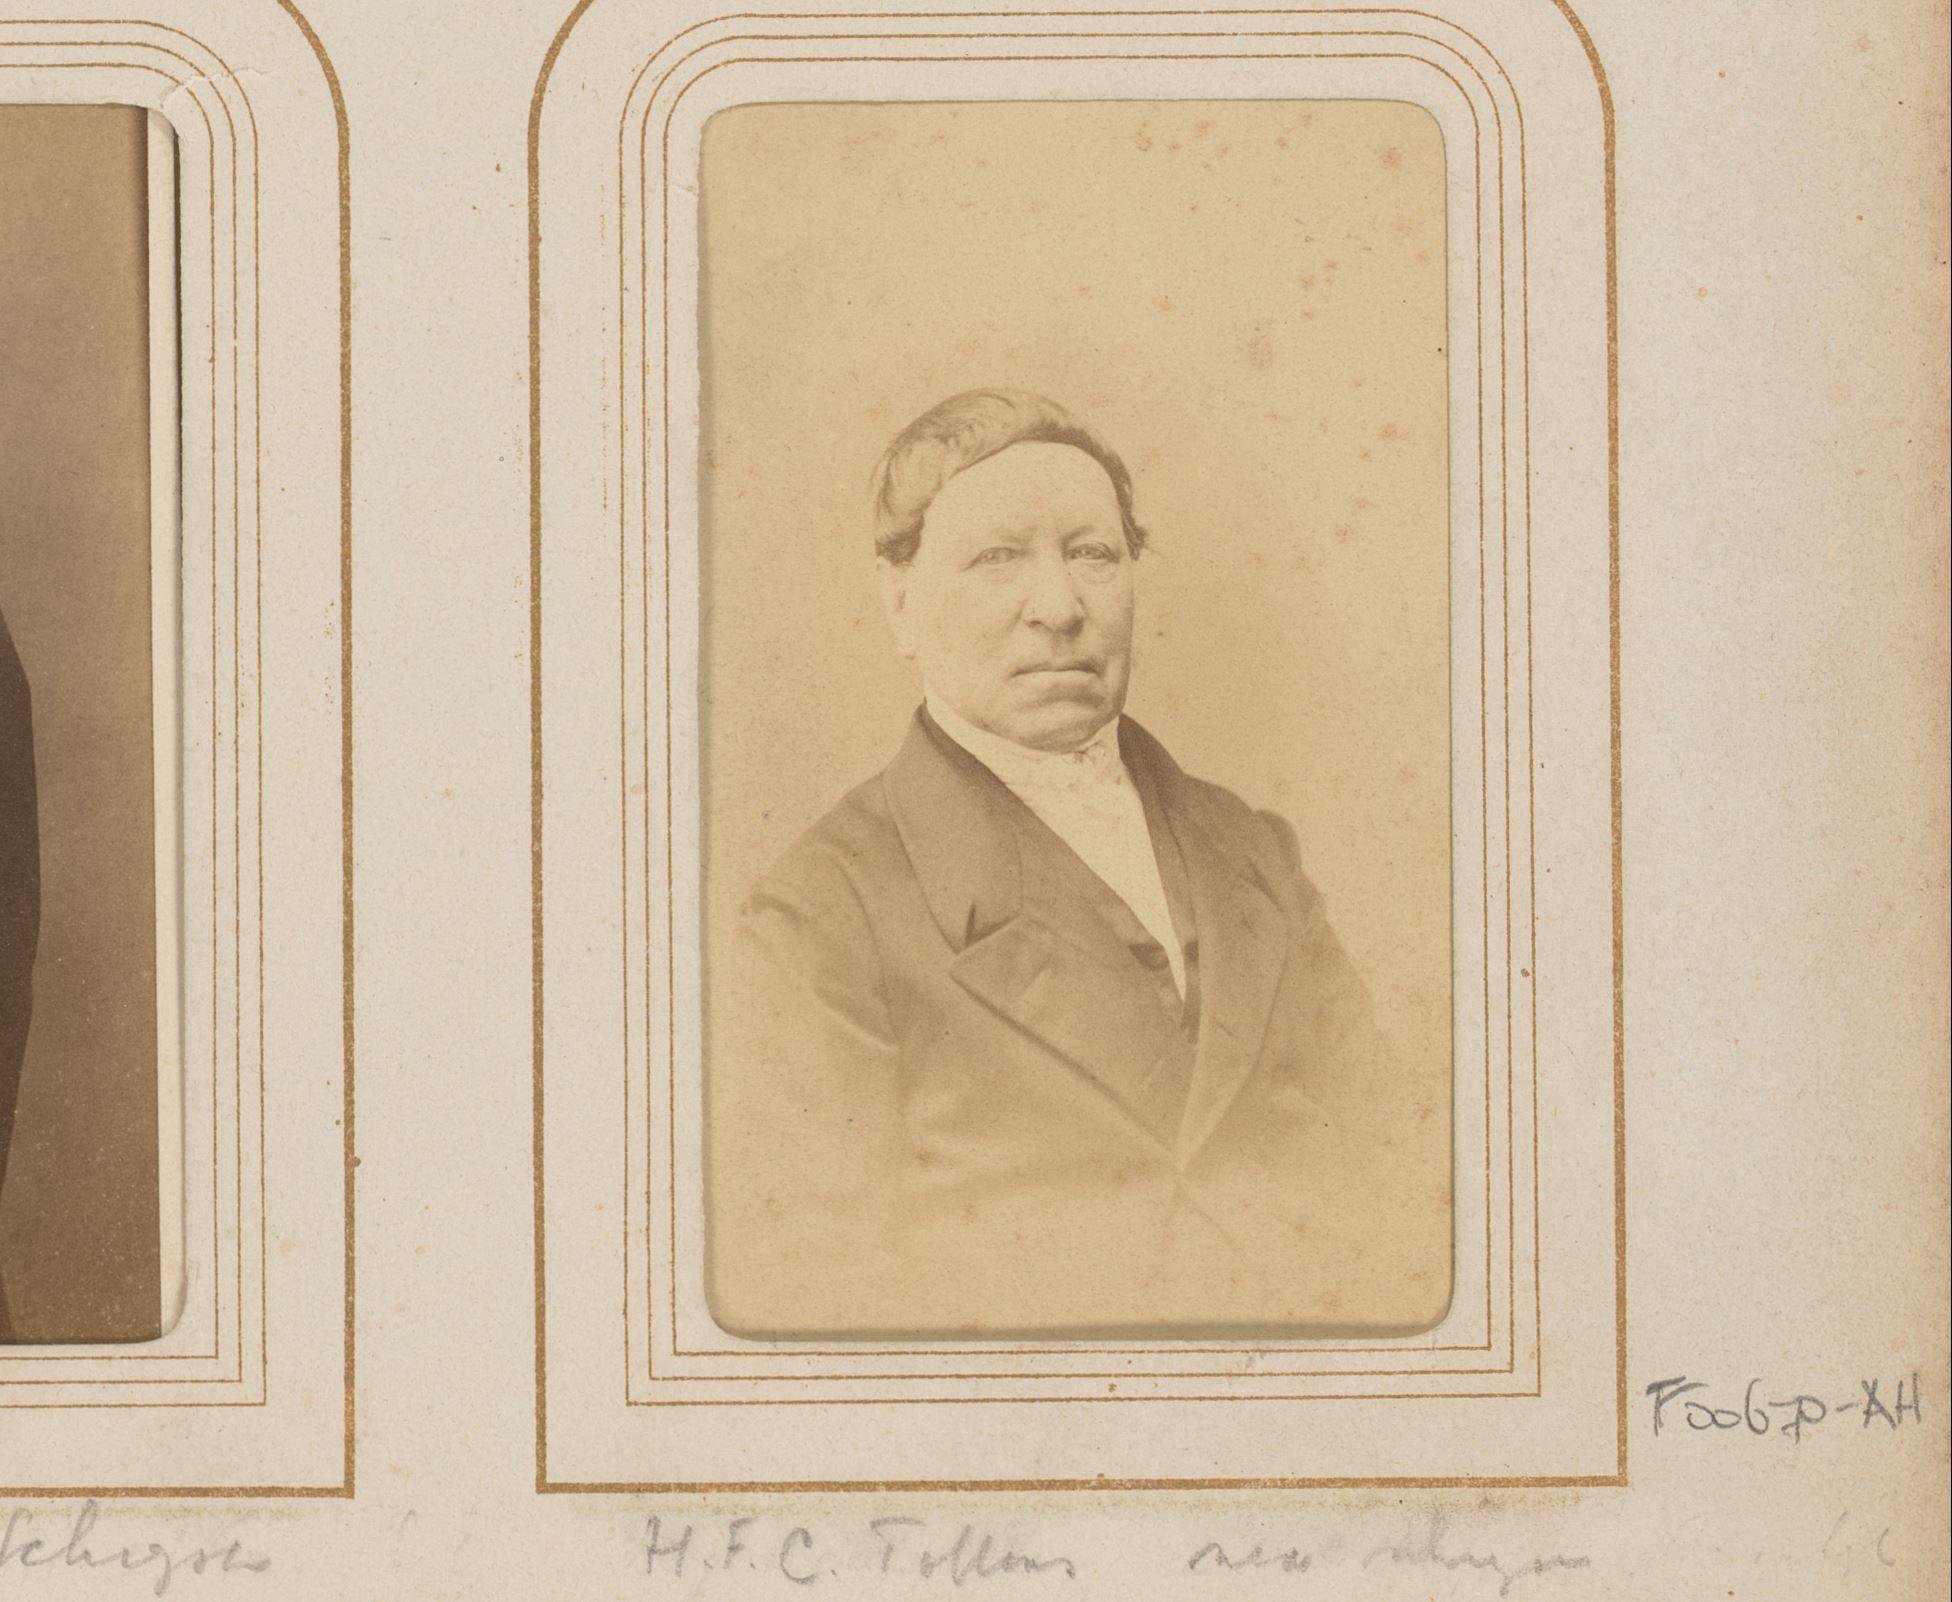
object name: album leaf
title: Portret van Hendrik Tollens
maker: johannes hinderikus egenberger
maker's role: draughtsman, print maker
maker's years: 1822-1897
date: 1850-1856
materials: cardboard, photographic support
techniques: albumen print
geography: groningen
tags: rotterdam, hendrik tollens, historical persons, writer, poet, author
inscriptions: inscription: ‘J.H. Egenberger/ Groningen’, annotation: ‘[...] 28/8150/ H. Tollens [...]’, annotation: ‘H.F.C. Tollens ned. schrijver/ 1780-1856 (Egenberger)’